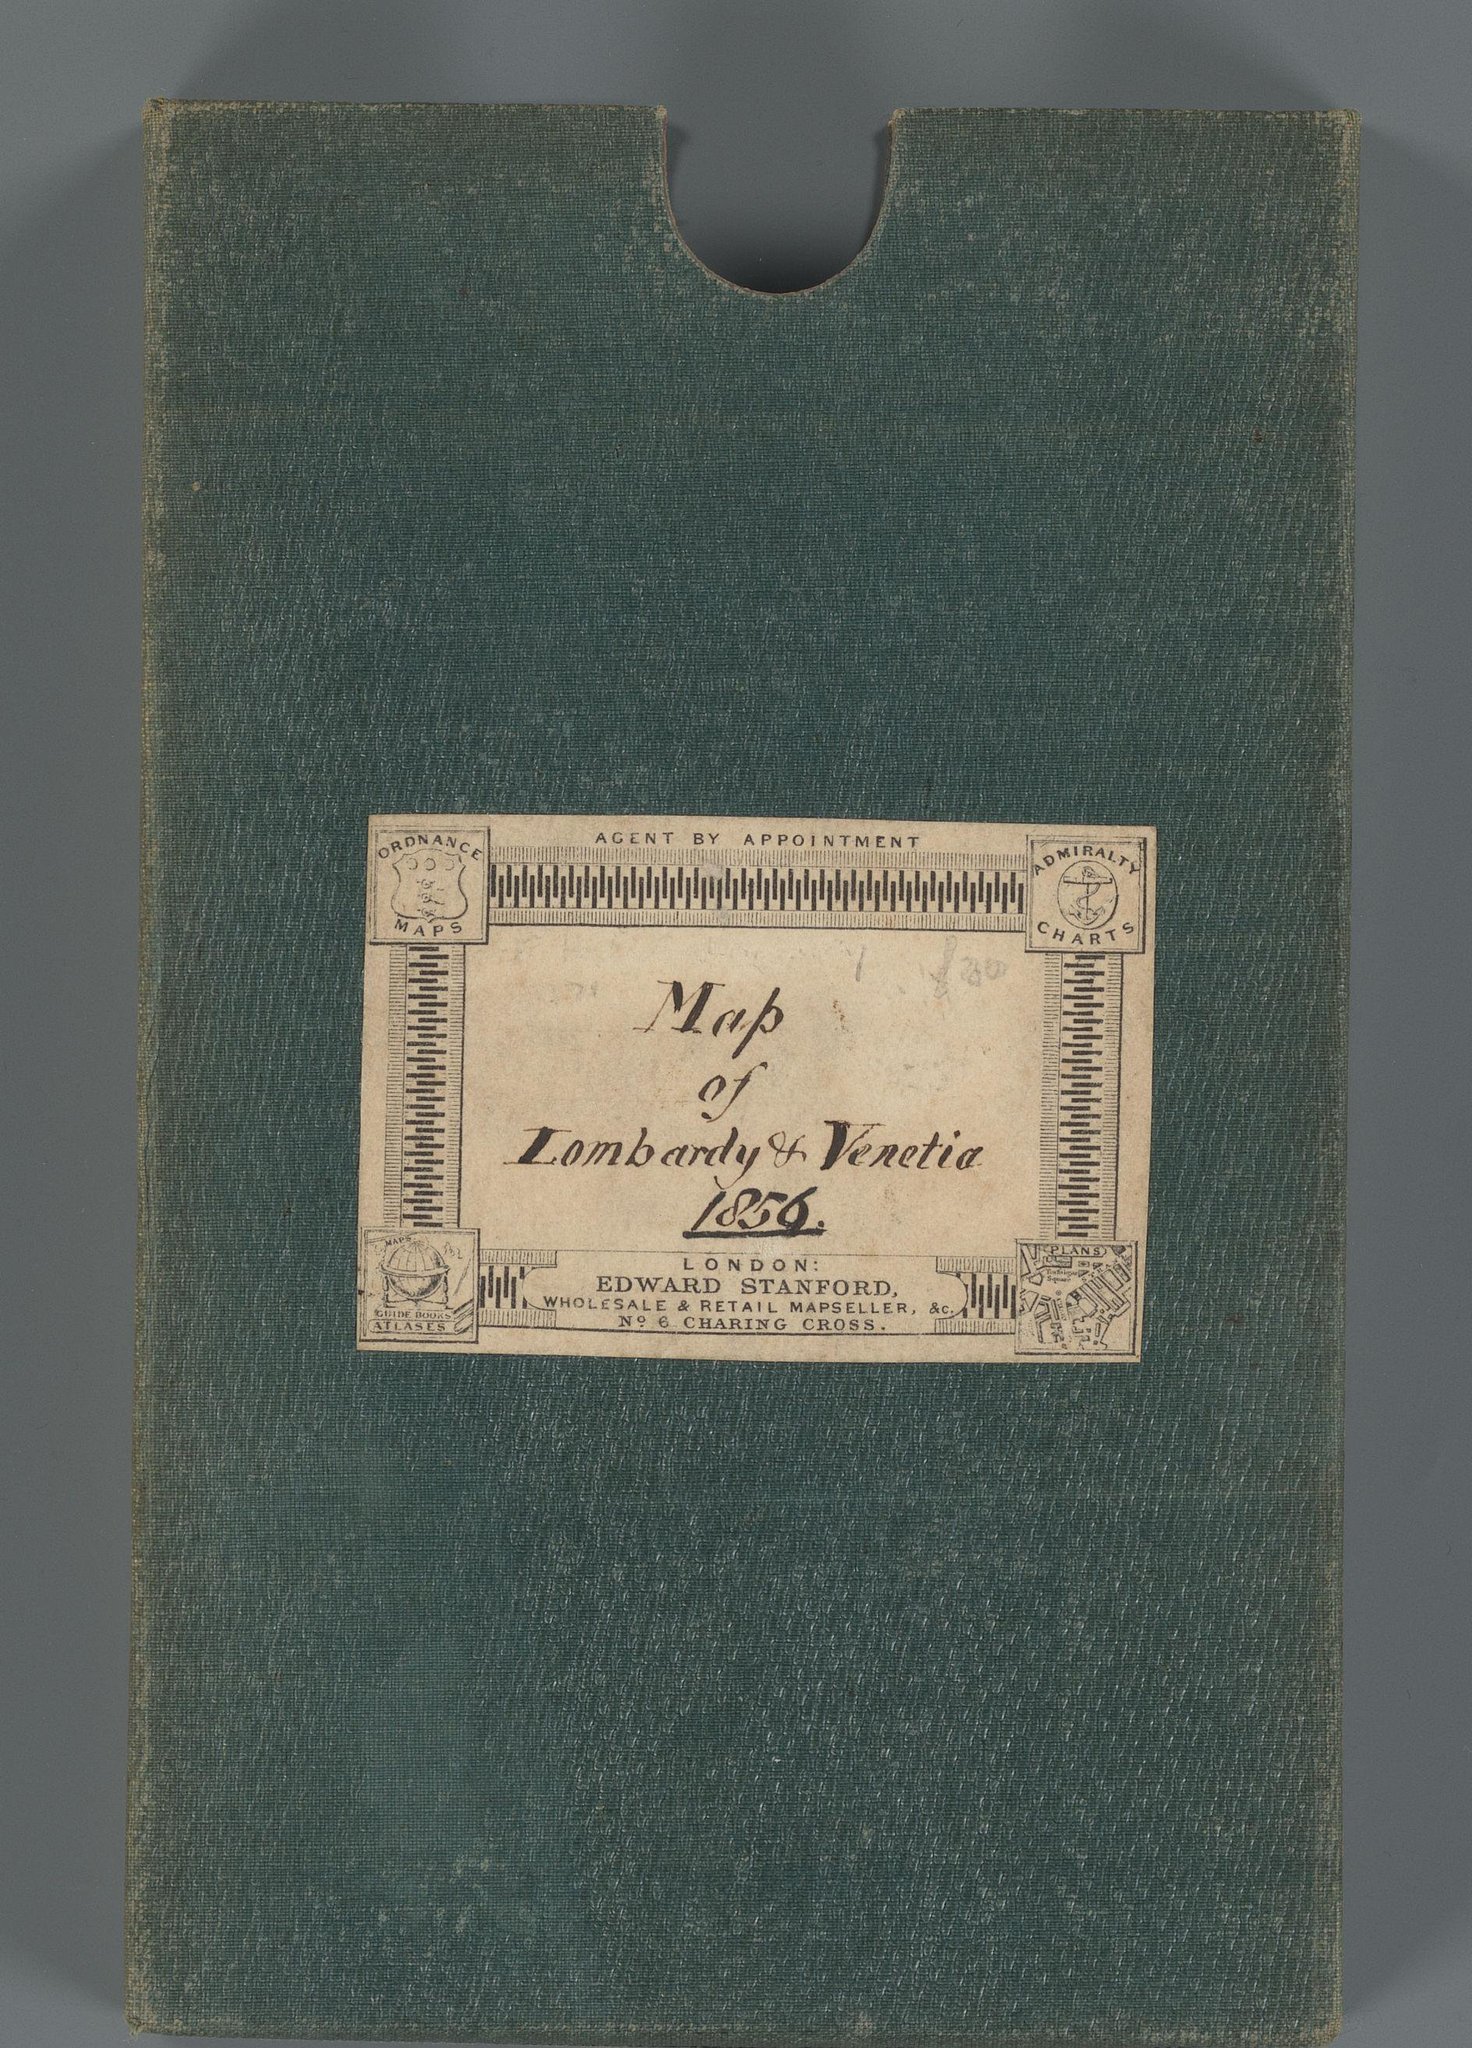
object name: cassette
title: Map of Lombardy and Venetia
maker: edward stanford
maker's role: fotograaf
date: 1856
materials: cardboard, linen, paper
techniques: albumen print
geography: london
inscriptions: inscription: ‘ORDNANCE/ MAPS/ AGENT BY APPOINT MENT/ ADMIRALTY/ CHARTS/ LONDON:/ EDWARD STANFORD,/ WHOLESALE & RETAIL MAPSELLER, &c./ No. 6 CHARING CROSS.’